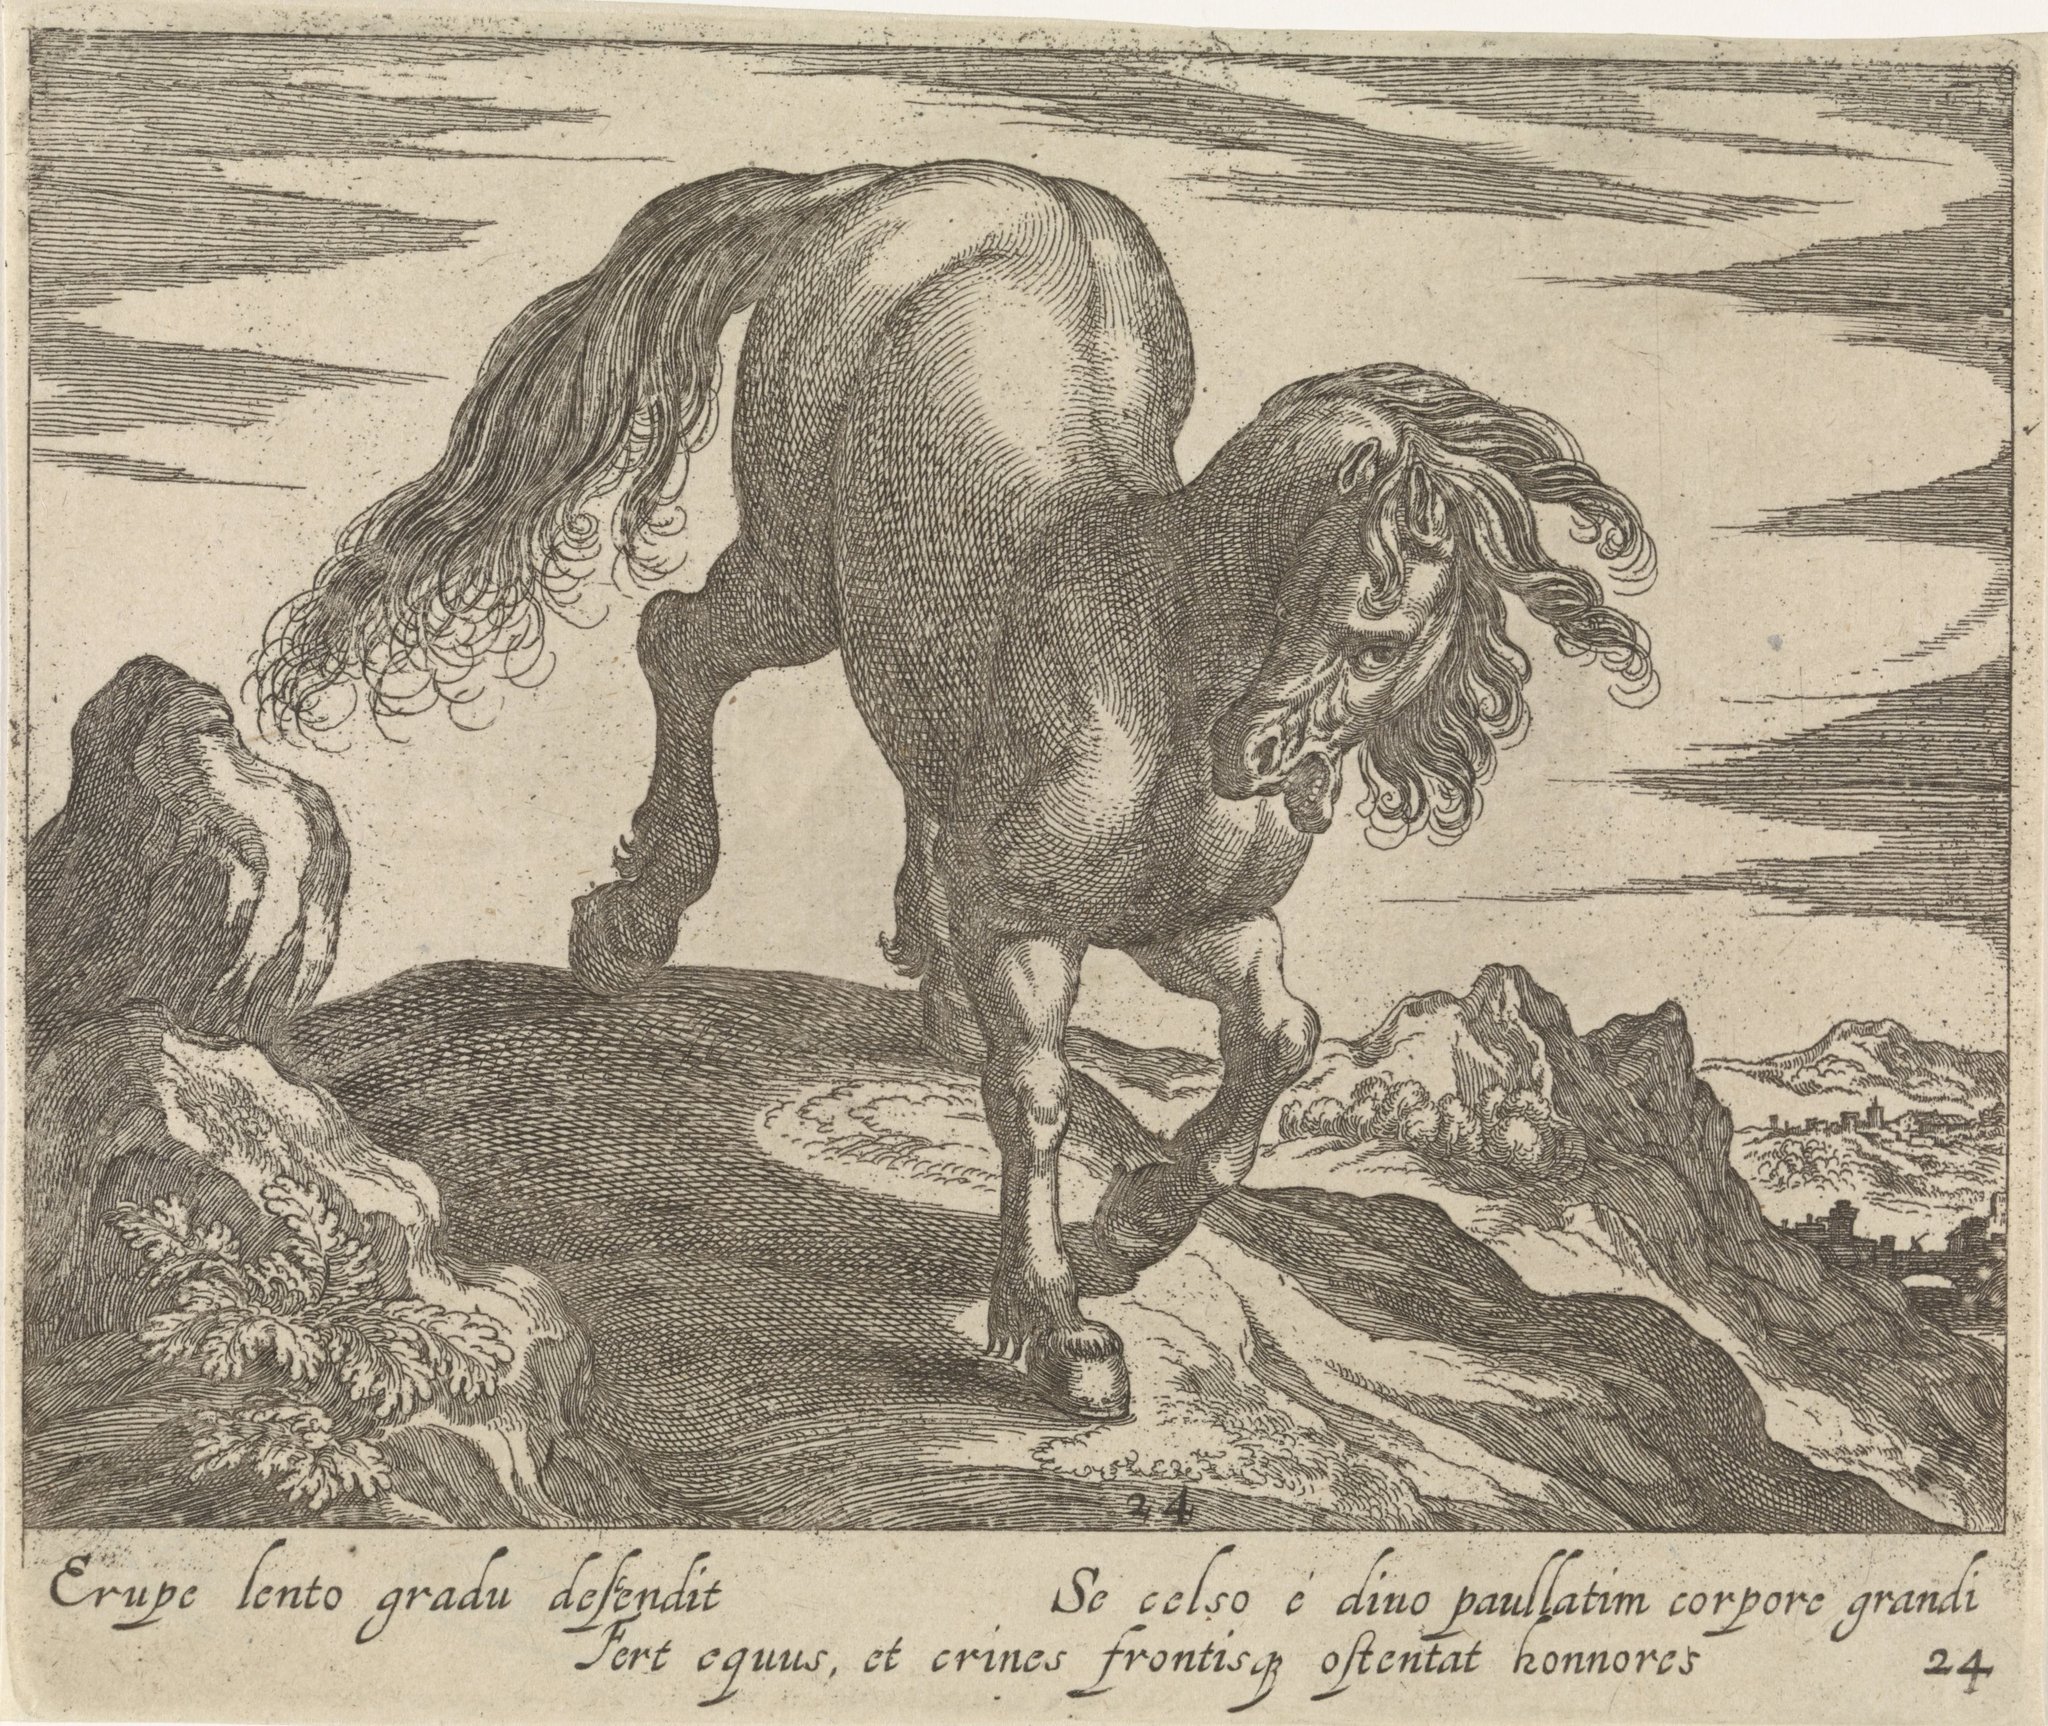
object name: print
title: Paardenrassen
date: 1590-1637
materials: paper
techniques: engraving, etching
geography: amsterdam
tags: horse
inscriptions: collector's mark: Lugt 2228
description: Bergachtig landschap met een paard, lopend op een heuvel. van voren gezien. In de marge een tweeregelig onderschrift in het Latijn. Prent uit een serie van dertig met paardenrassen.